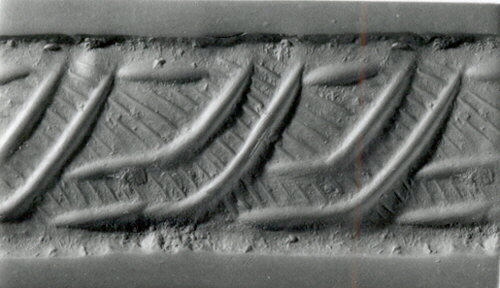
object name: cylinder seal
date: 2900-2700 BCE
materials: stone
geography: mesopotamia